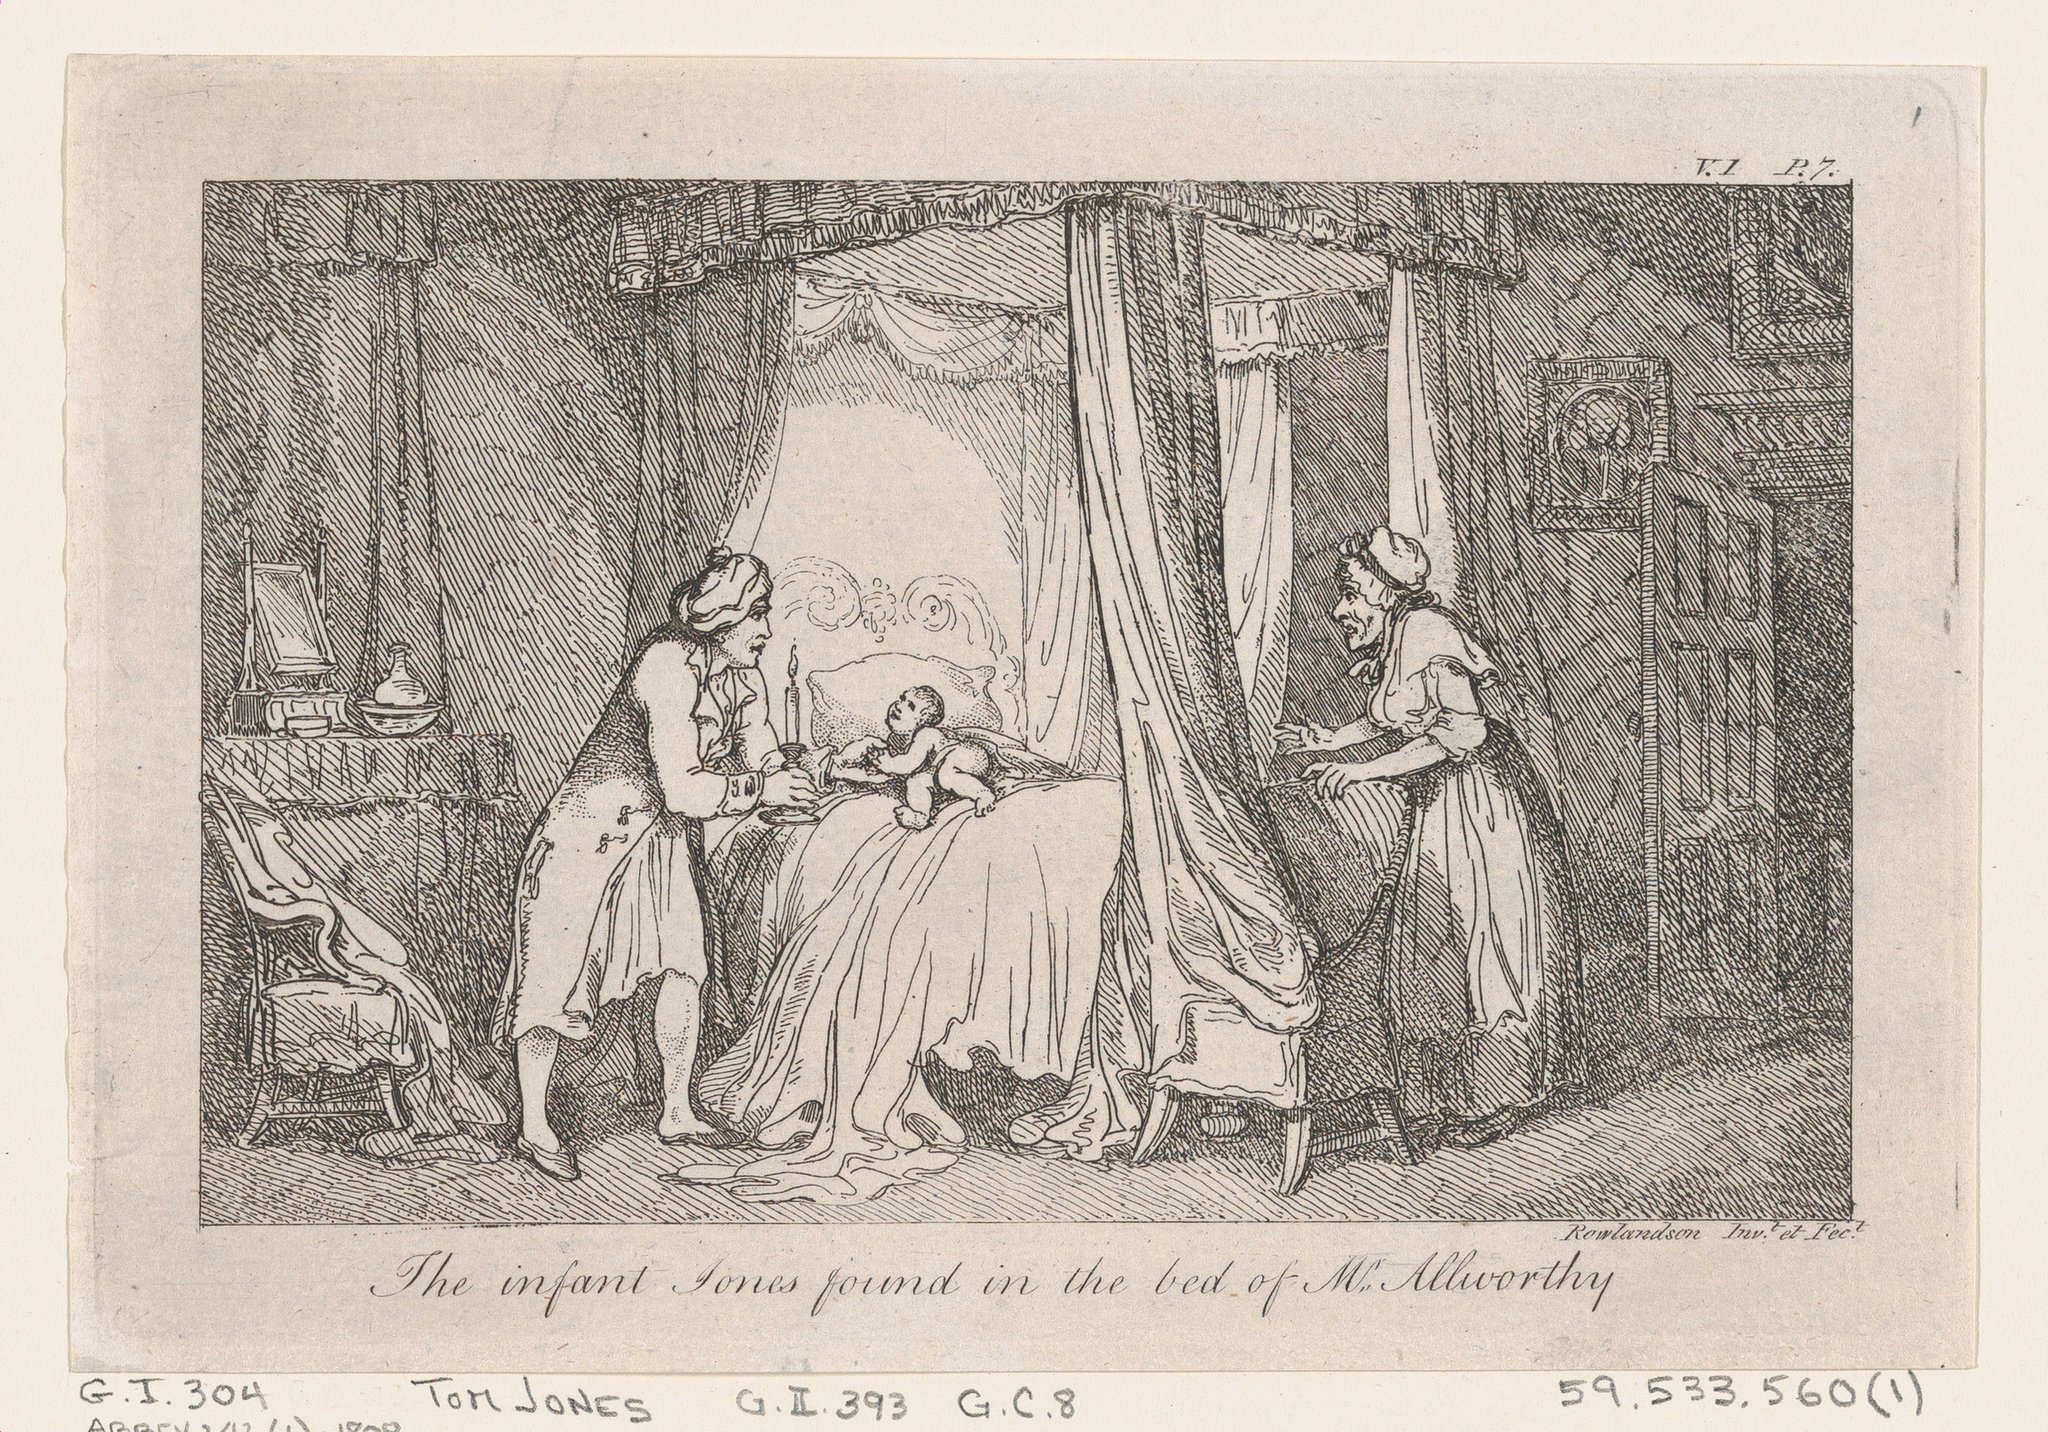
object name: print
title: The infant Jones found in the bed of Mr. Allworthy, from "The History of Tom Jones, a Foundling"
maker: thomas rowlandson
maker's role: artist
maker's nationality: british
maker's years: 1757-1827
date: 1792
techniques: etching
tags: bedrooms,infants,men,women,beds